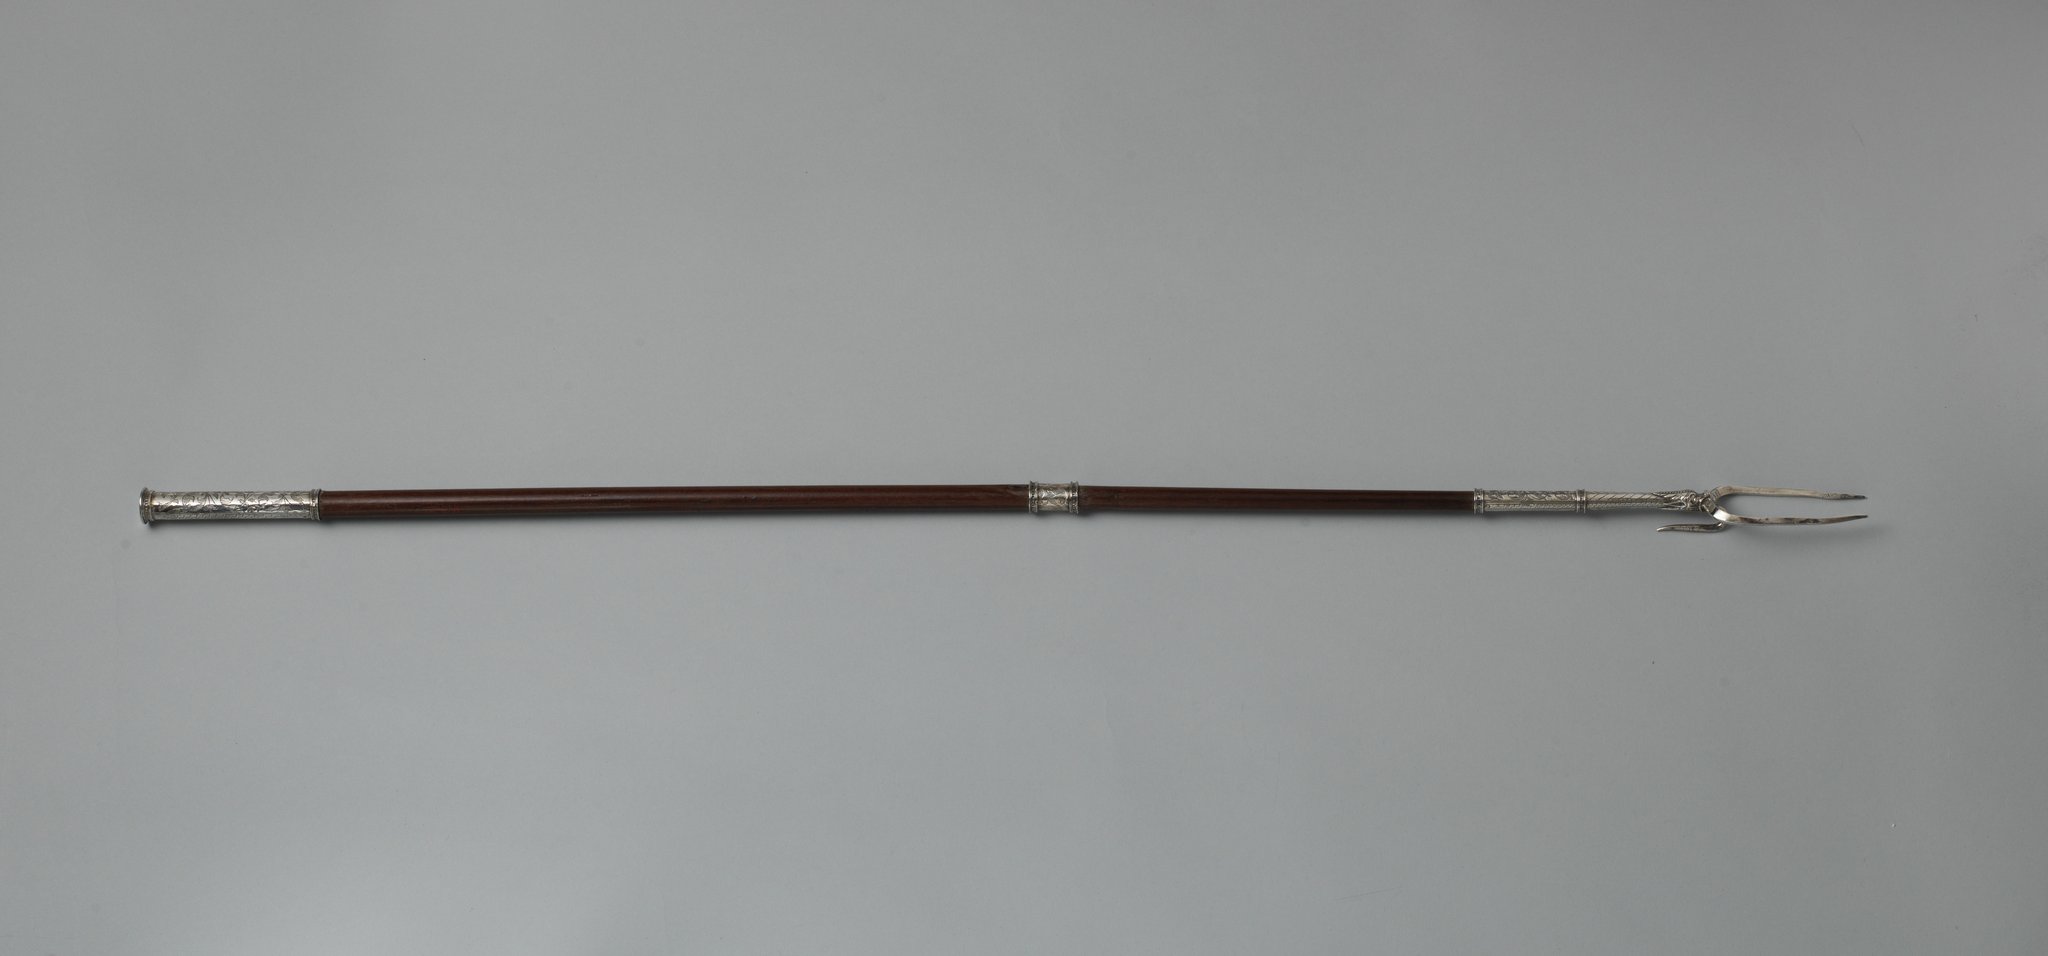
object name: toasting fork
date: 1561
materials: wood, silver